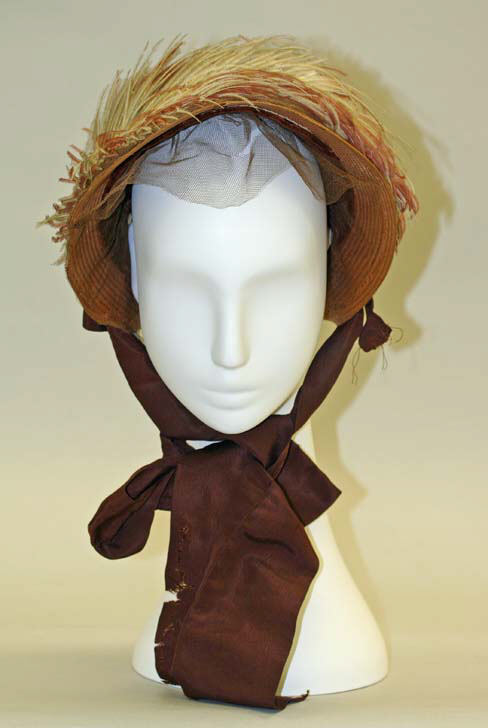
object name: bonnet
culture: american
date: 1882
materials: fiber